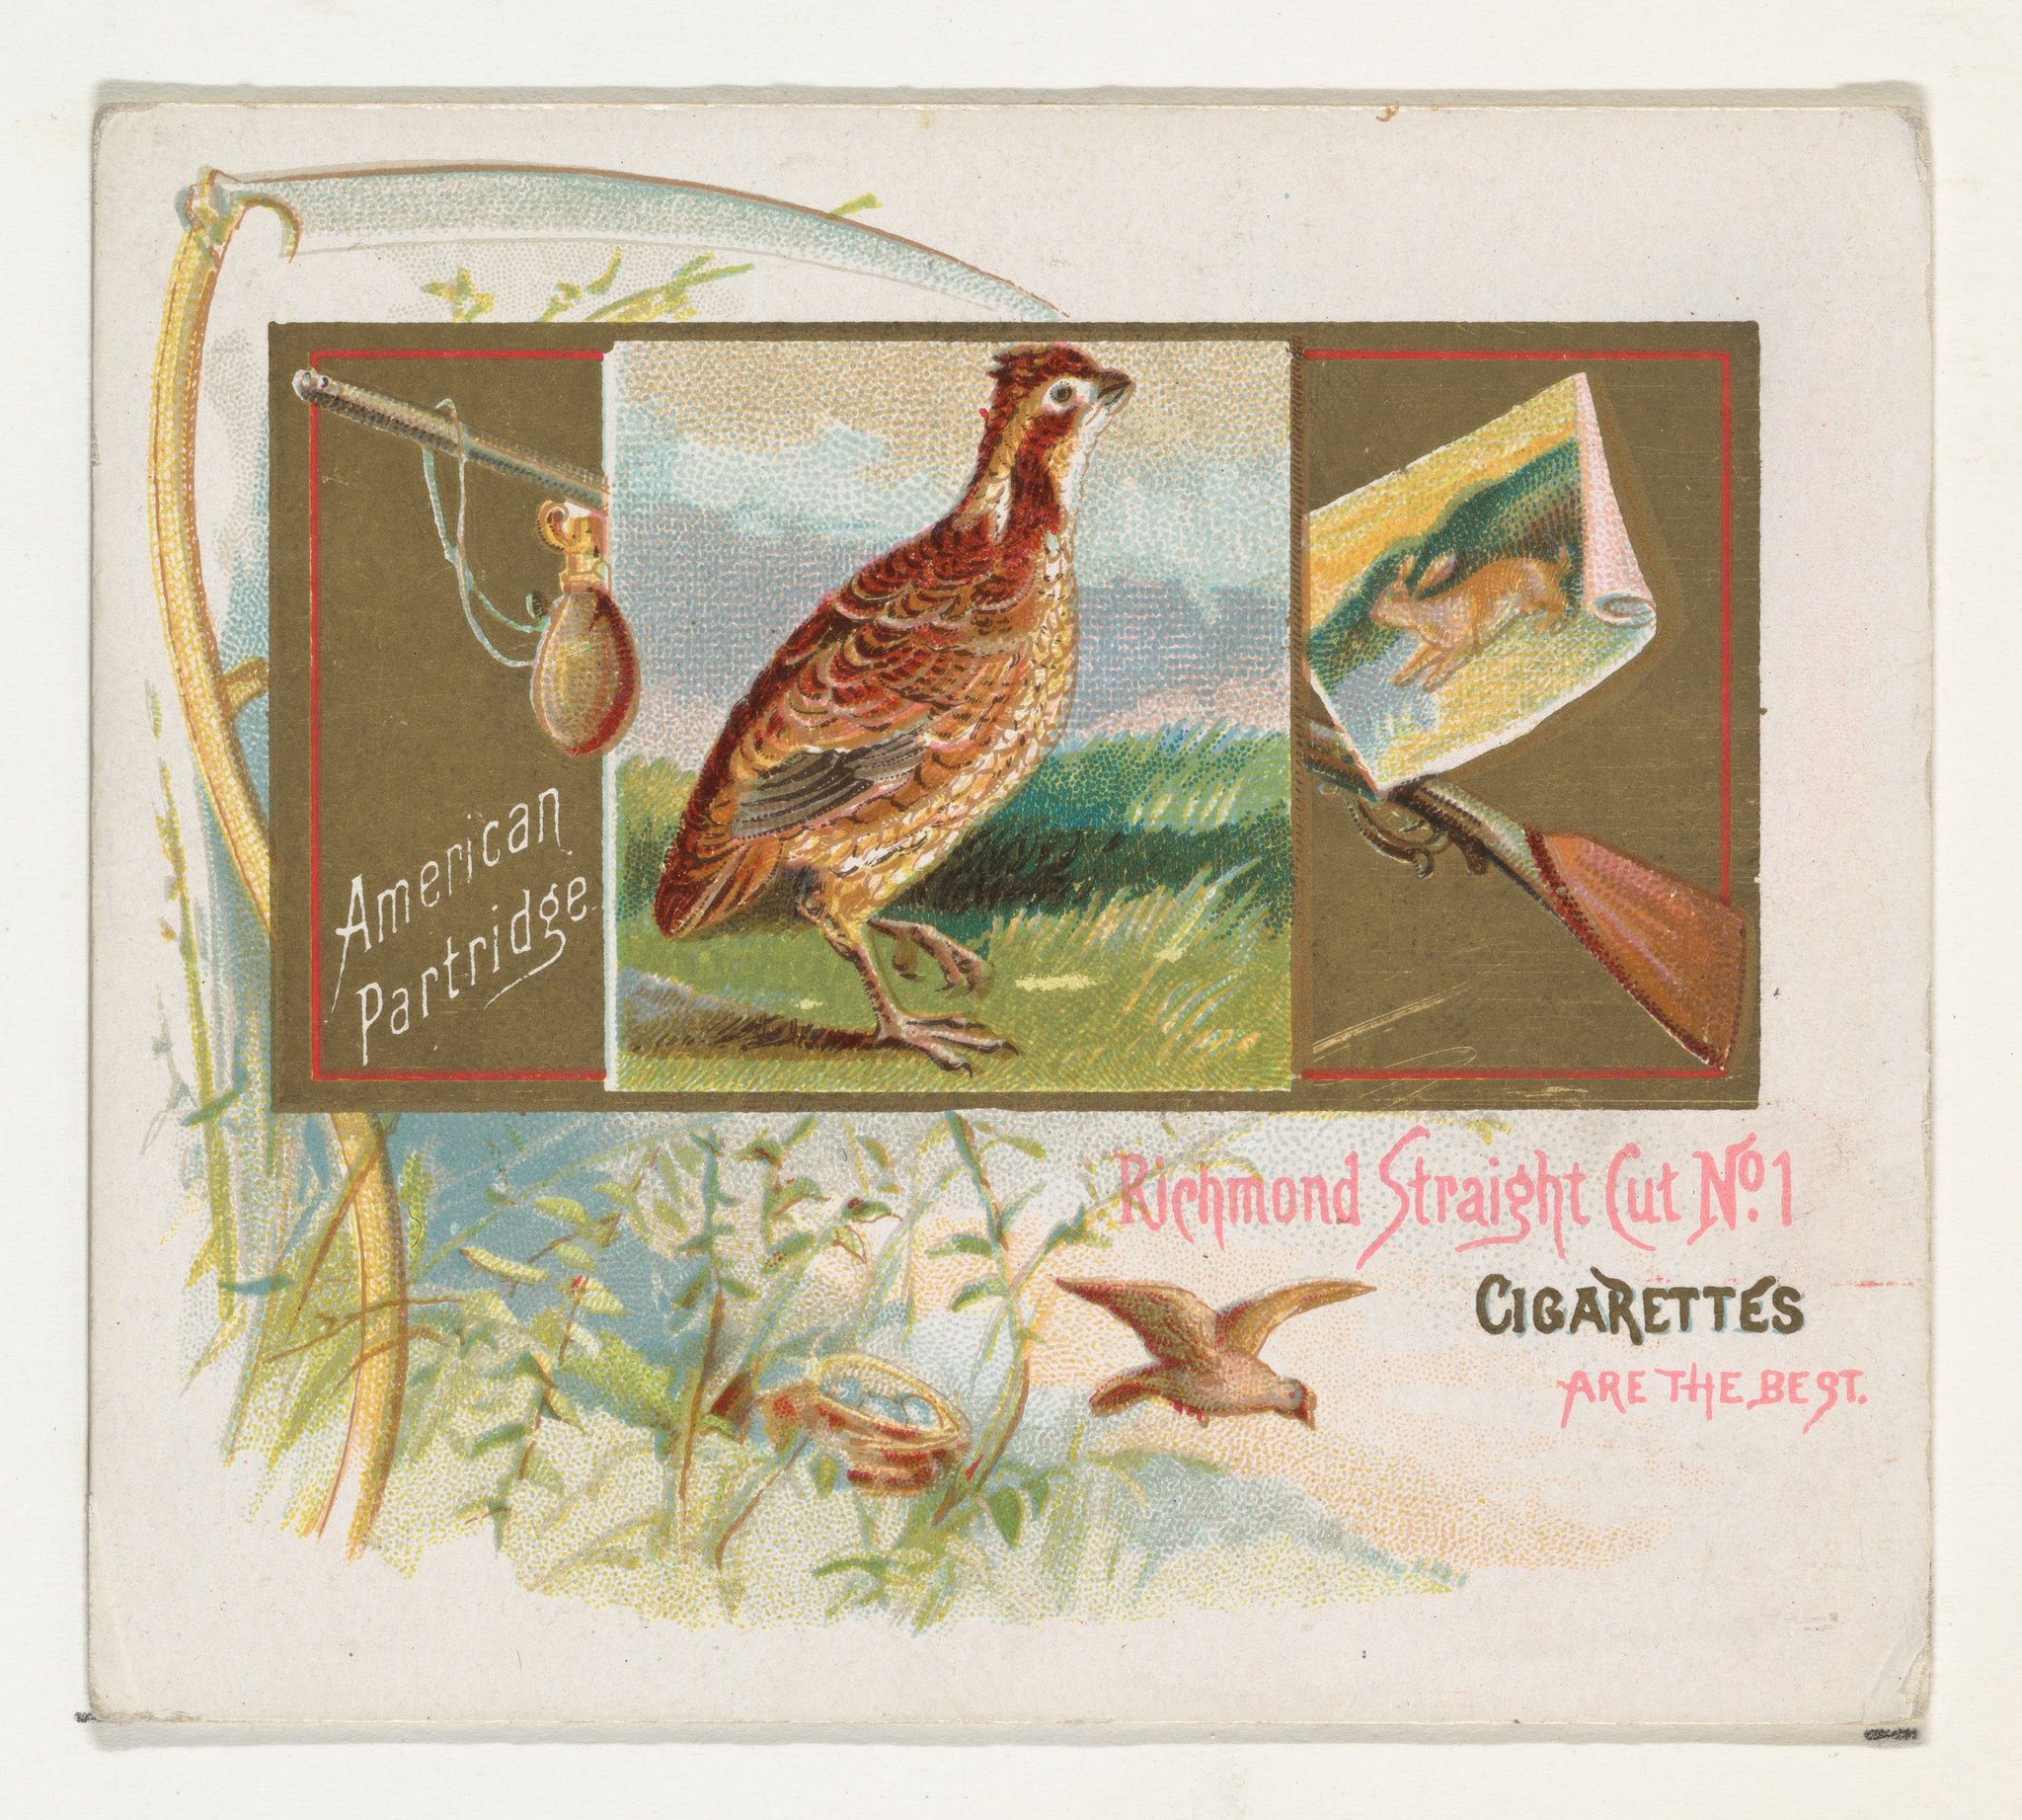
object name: print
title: American Partridge, from the Game Birds series (N40) for Allen & Ginter Cigarettes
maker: allen & ginter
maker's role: publisher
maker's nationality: american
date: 1888-1890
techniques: color lithograph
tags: birds